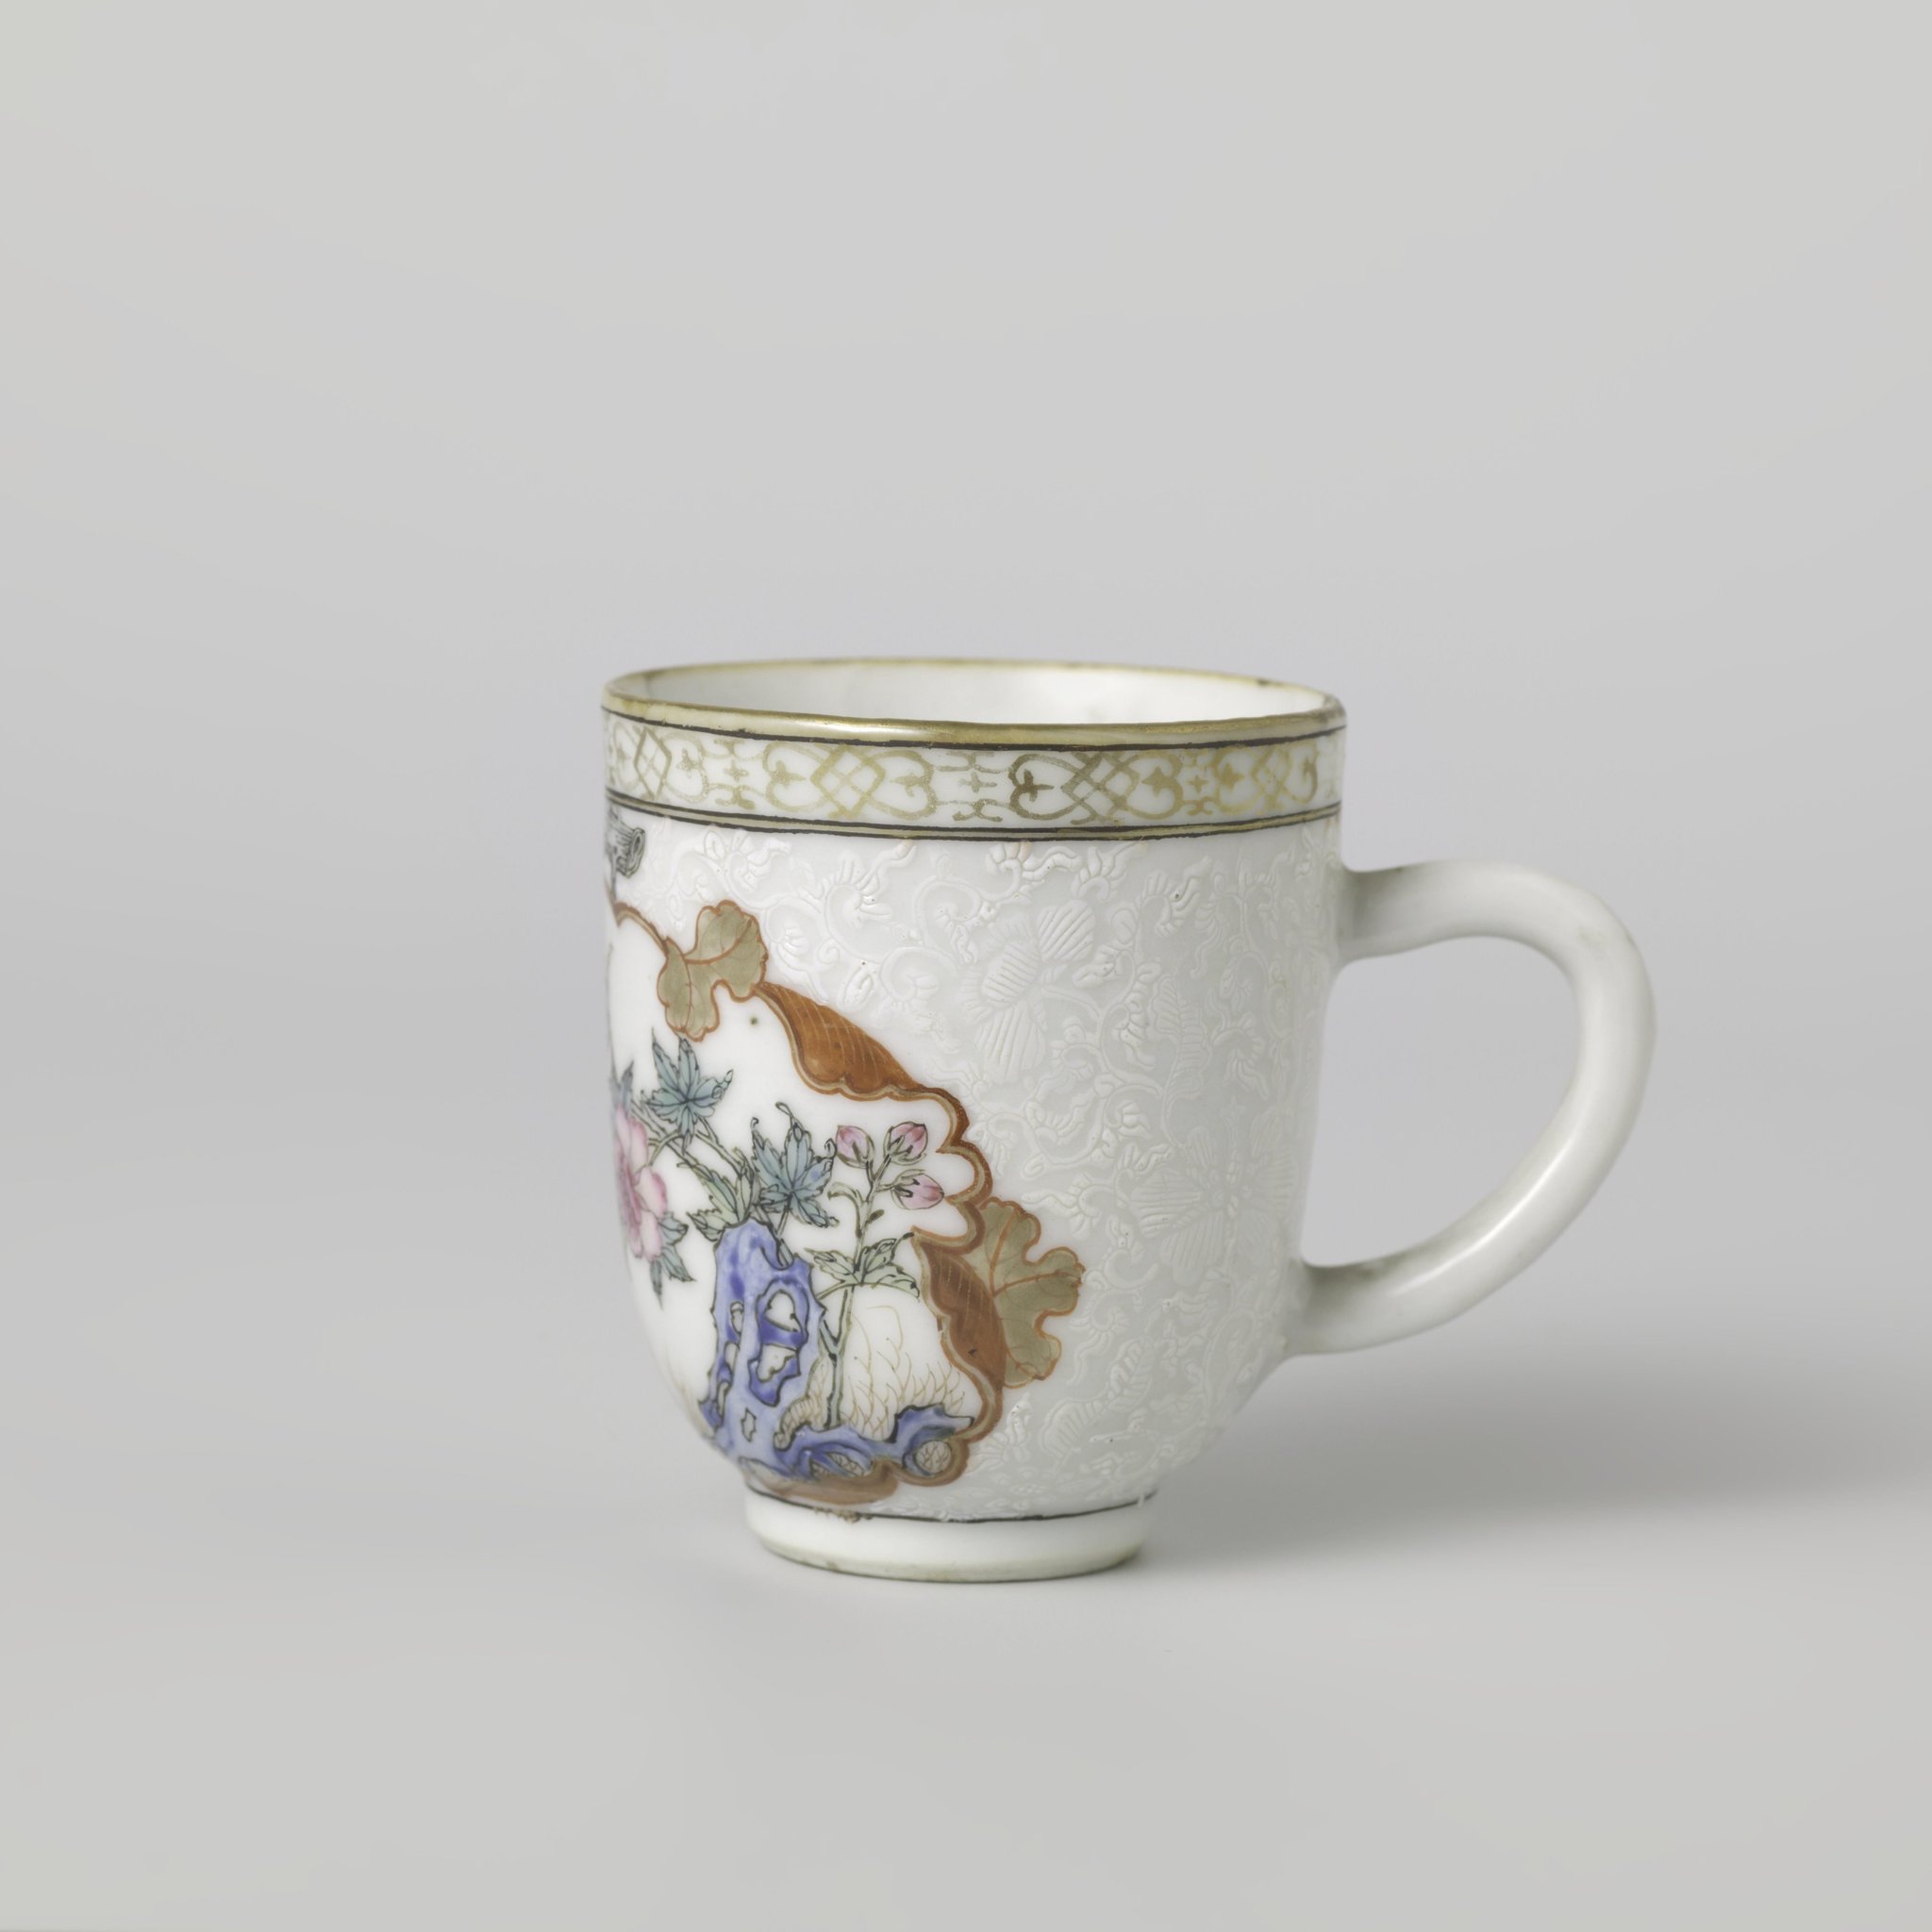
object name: oorkop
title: Cup with handle with a crane near a peony plant and rock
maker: Anonymous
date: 1725-1749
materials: glaze, gold, paint, porcelain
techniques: firing, gilding, turning, vitrification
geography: china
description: Gedecoreerd in emails, goud en bianco sopra bianco met vogels en bloeiende planten.